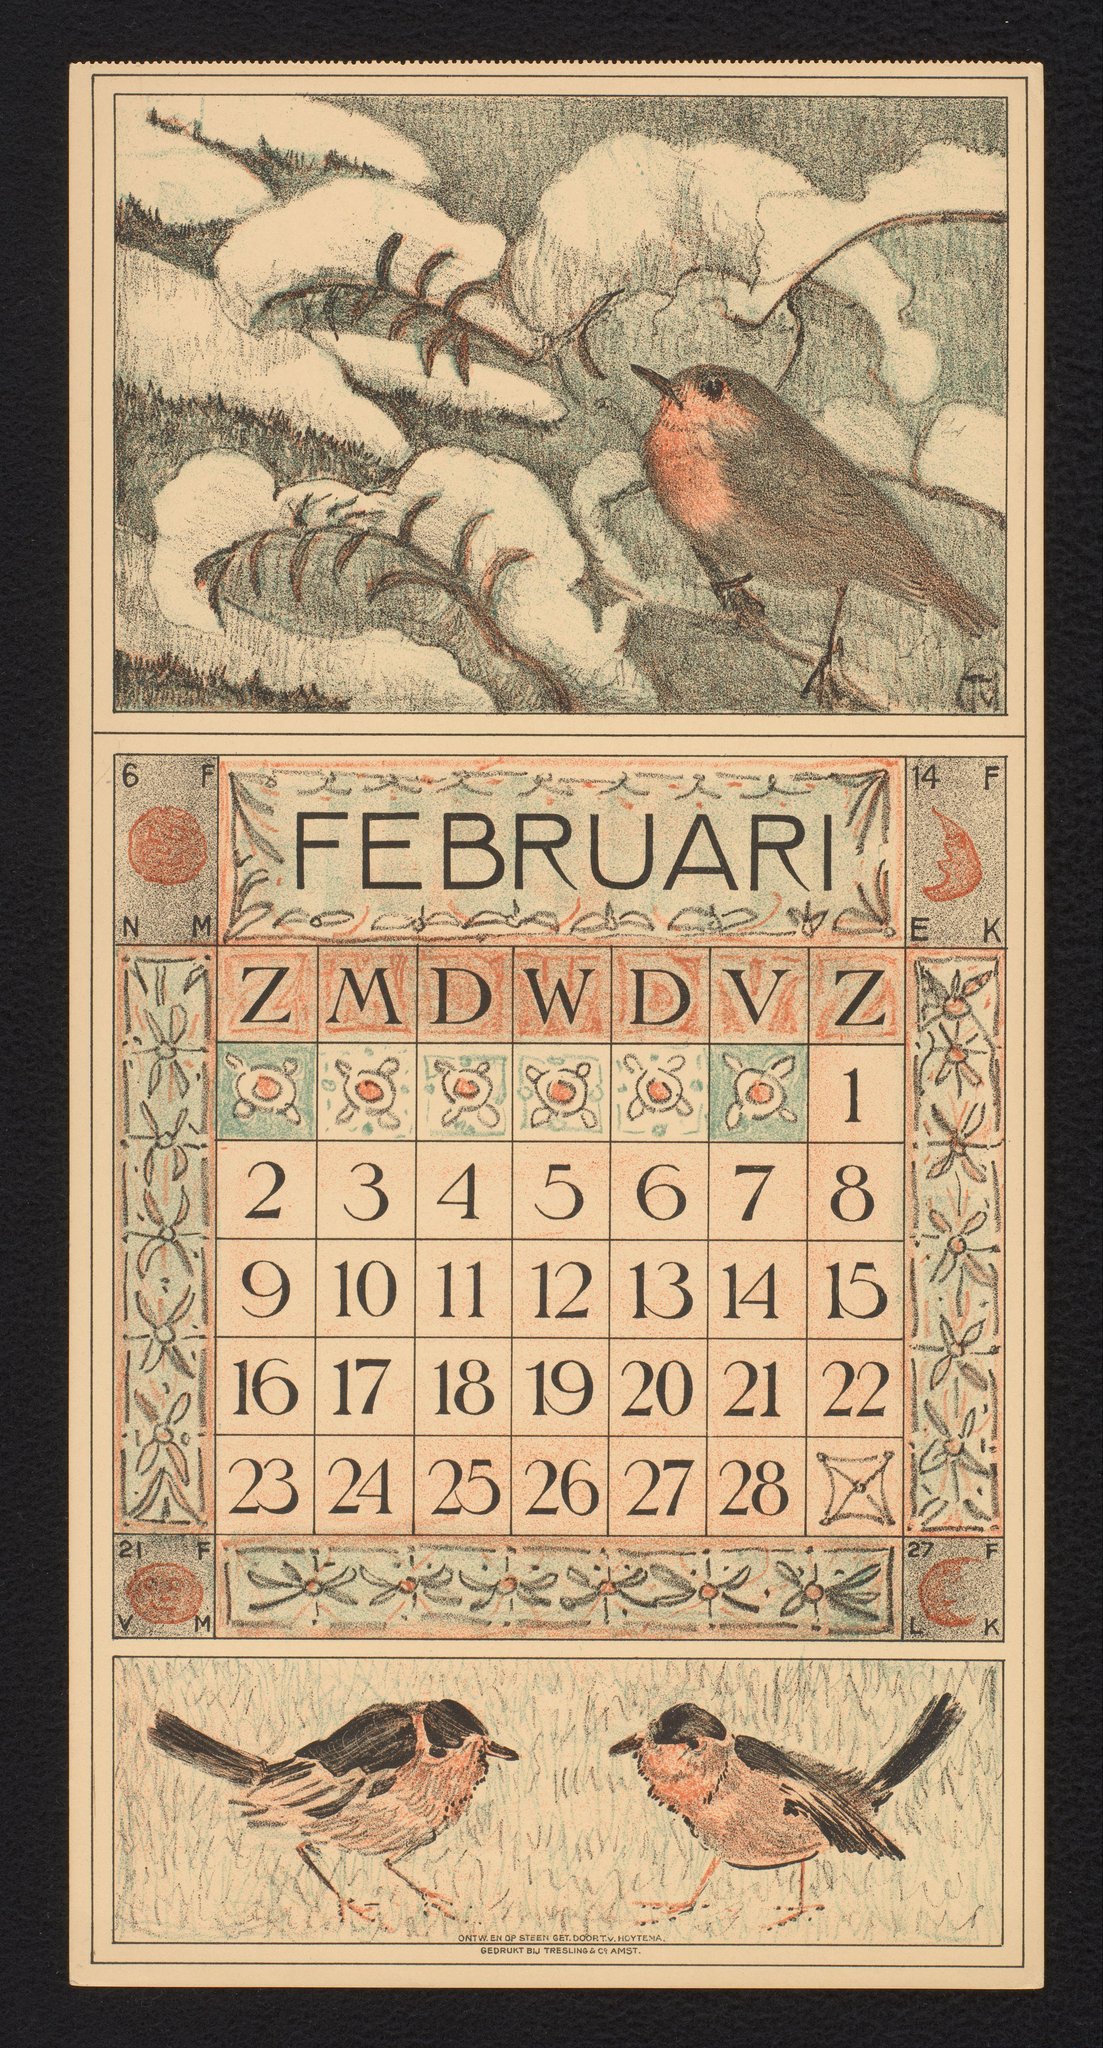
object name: calendar leaf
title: Kalenderblad voor februari 1913 met een roodborstje op een besneeuwde boomtak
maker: theo van hoytema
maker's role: draughtsman, painter, print maker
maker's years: 1863-1917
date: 1912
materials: paper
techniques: lithograph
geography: amsterdam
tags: song-birds: robin